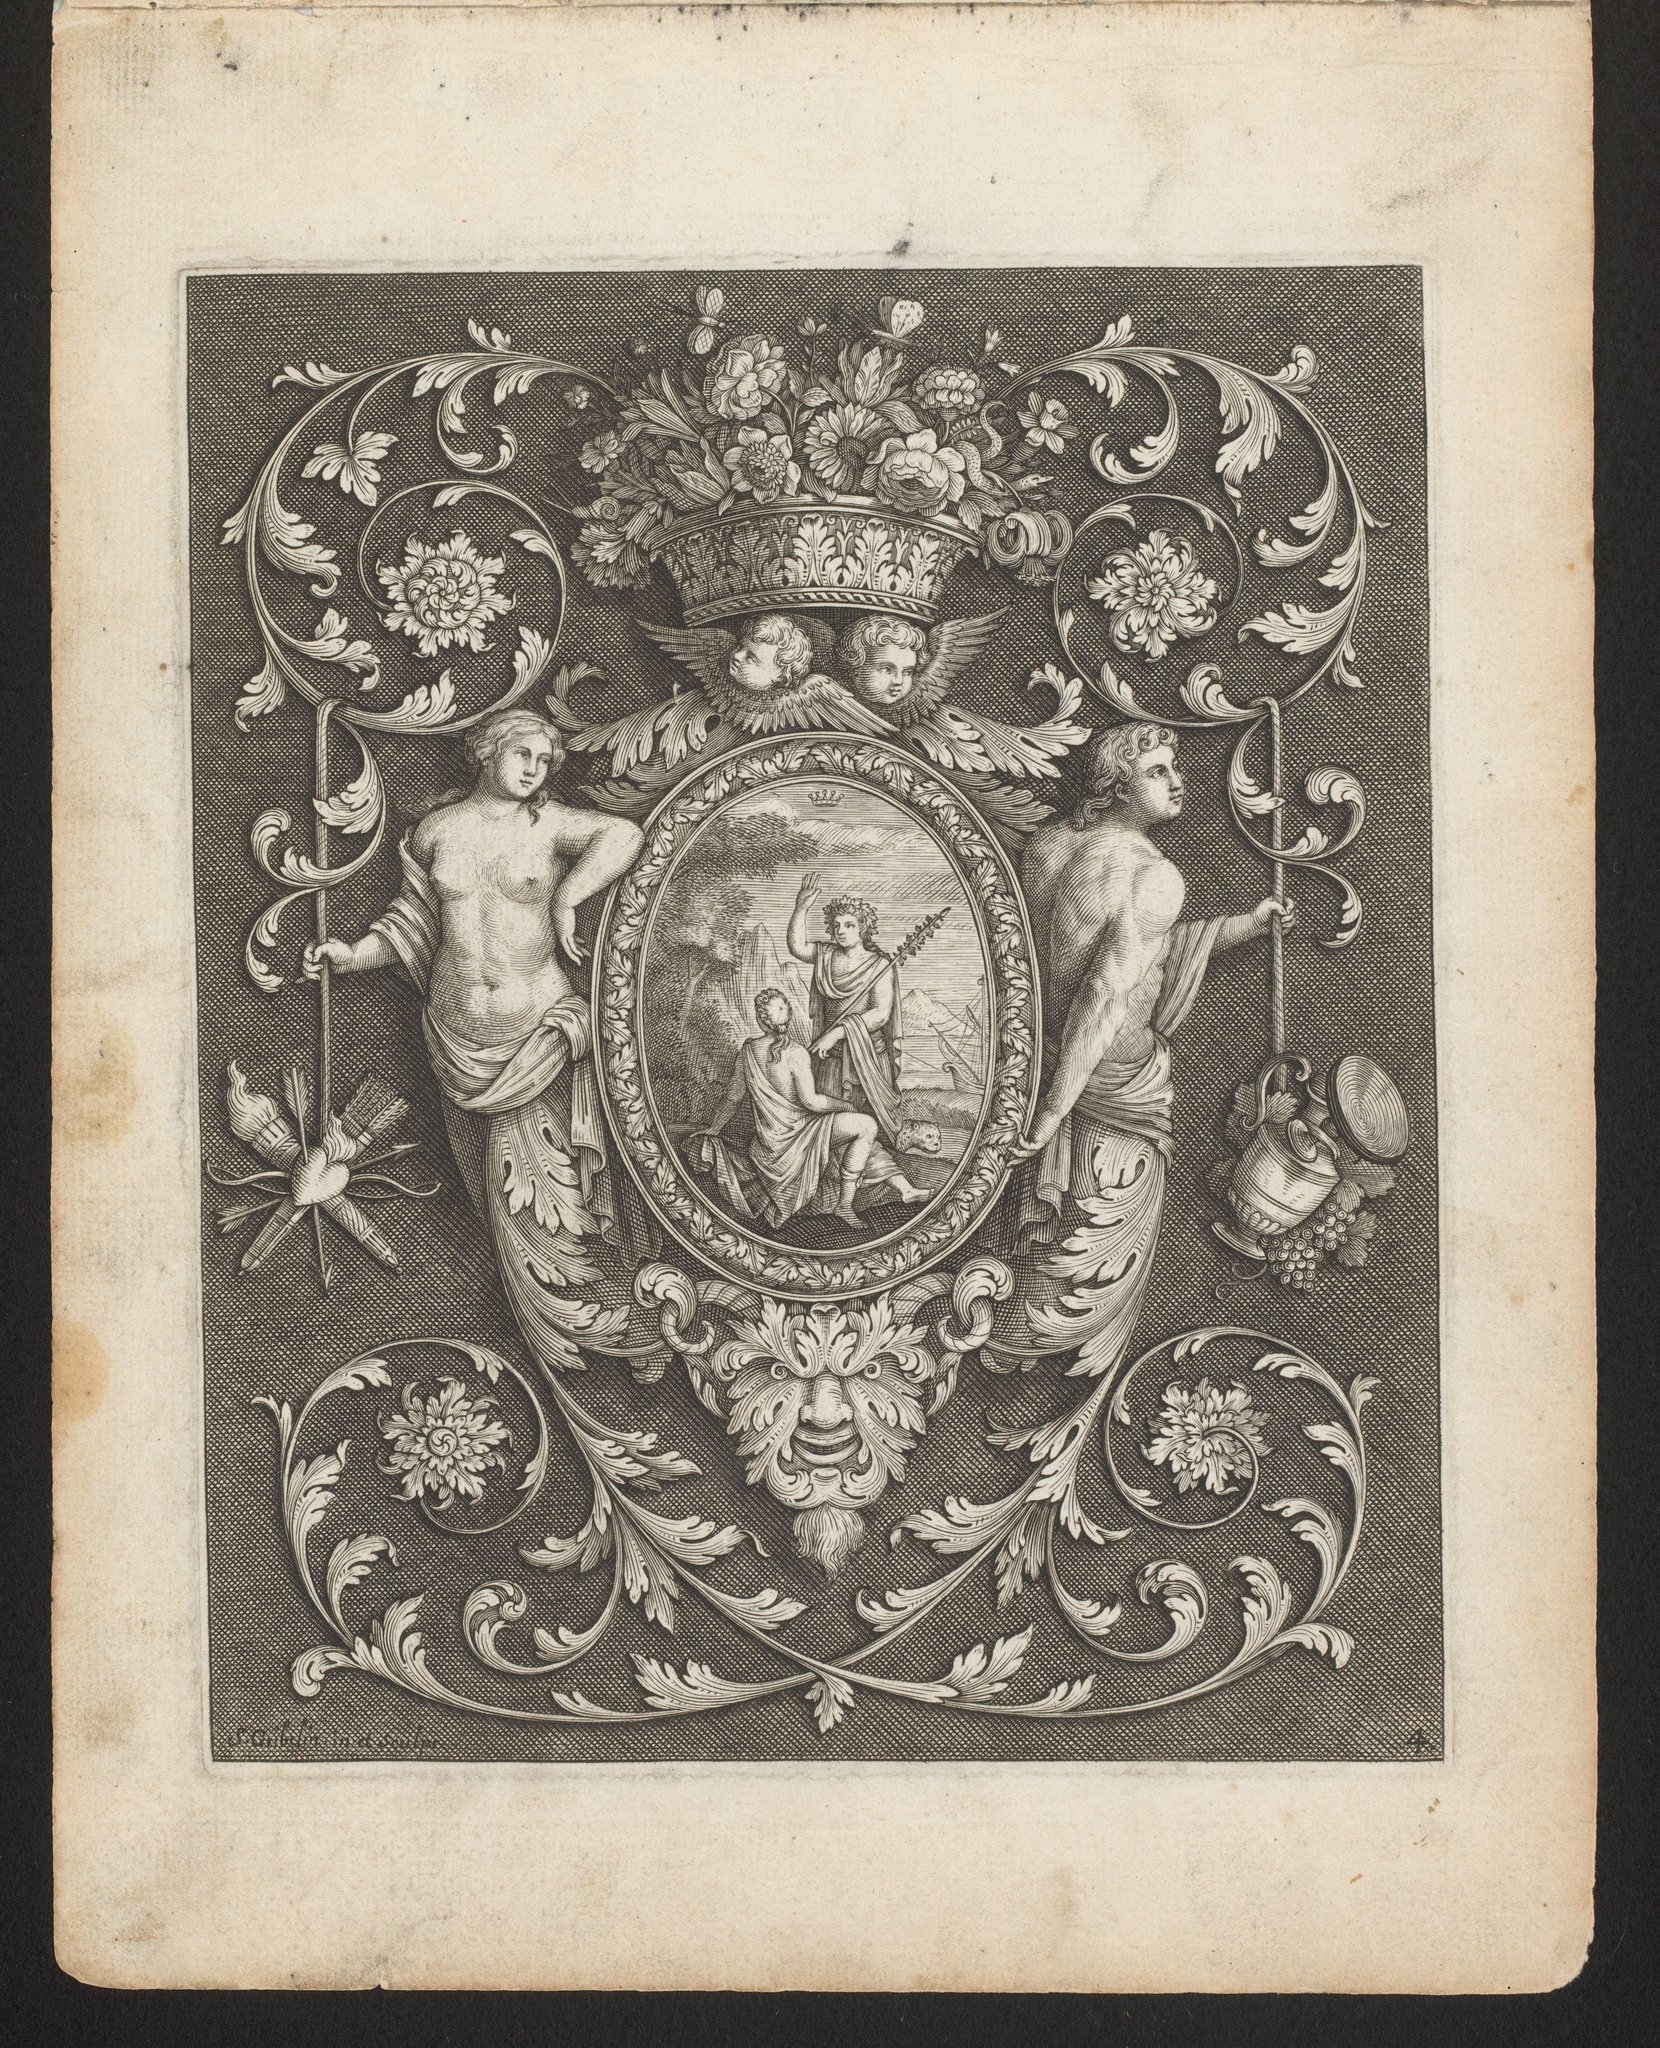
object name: print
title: Bacchus en Ariadne omgeven door bladvormige ornamenten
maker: simon gribelin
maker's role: print maker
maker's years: 1661-1733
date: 1704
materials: paper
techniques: engraving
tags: ornaments ~ art, 'tropaion', i.e. decorative ornament ~ weapons, (story of) ariadne and bacchus, cupids: 'amores', 'amoretti', 'putti', ornament derived from plant forms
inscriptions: collector's mark: Lugt 2228, collector's mark: Lugt 2760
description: De eerste versie van deze prentserie is uitgegeven in 1682 met de titel 'A Book of Severall Ornaments'.